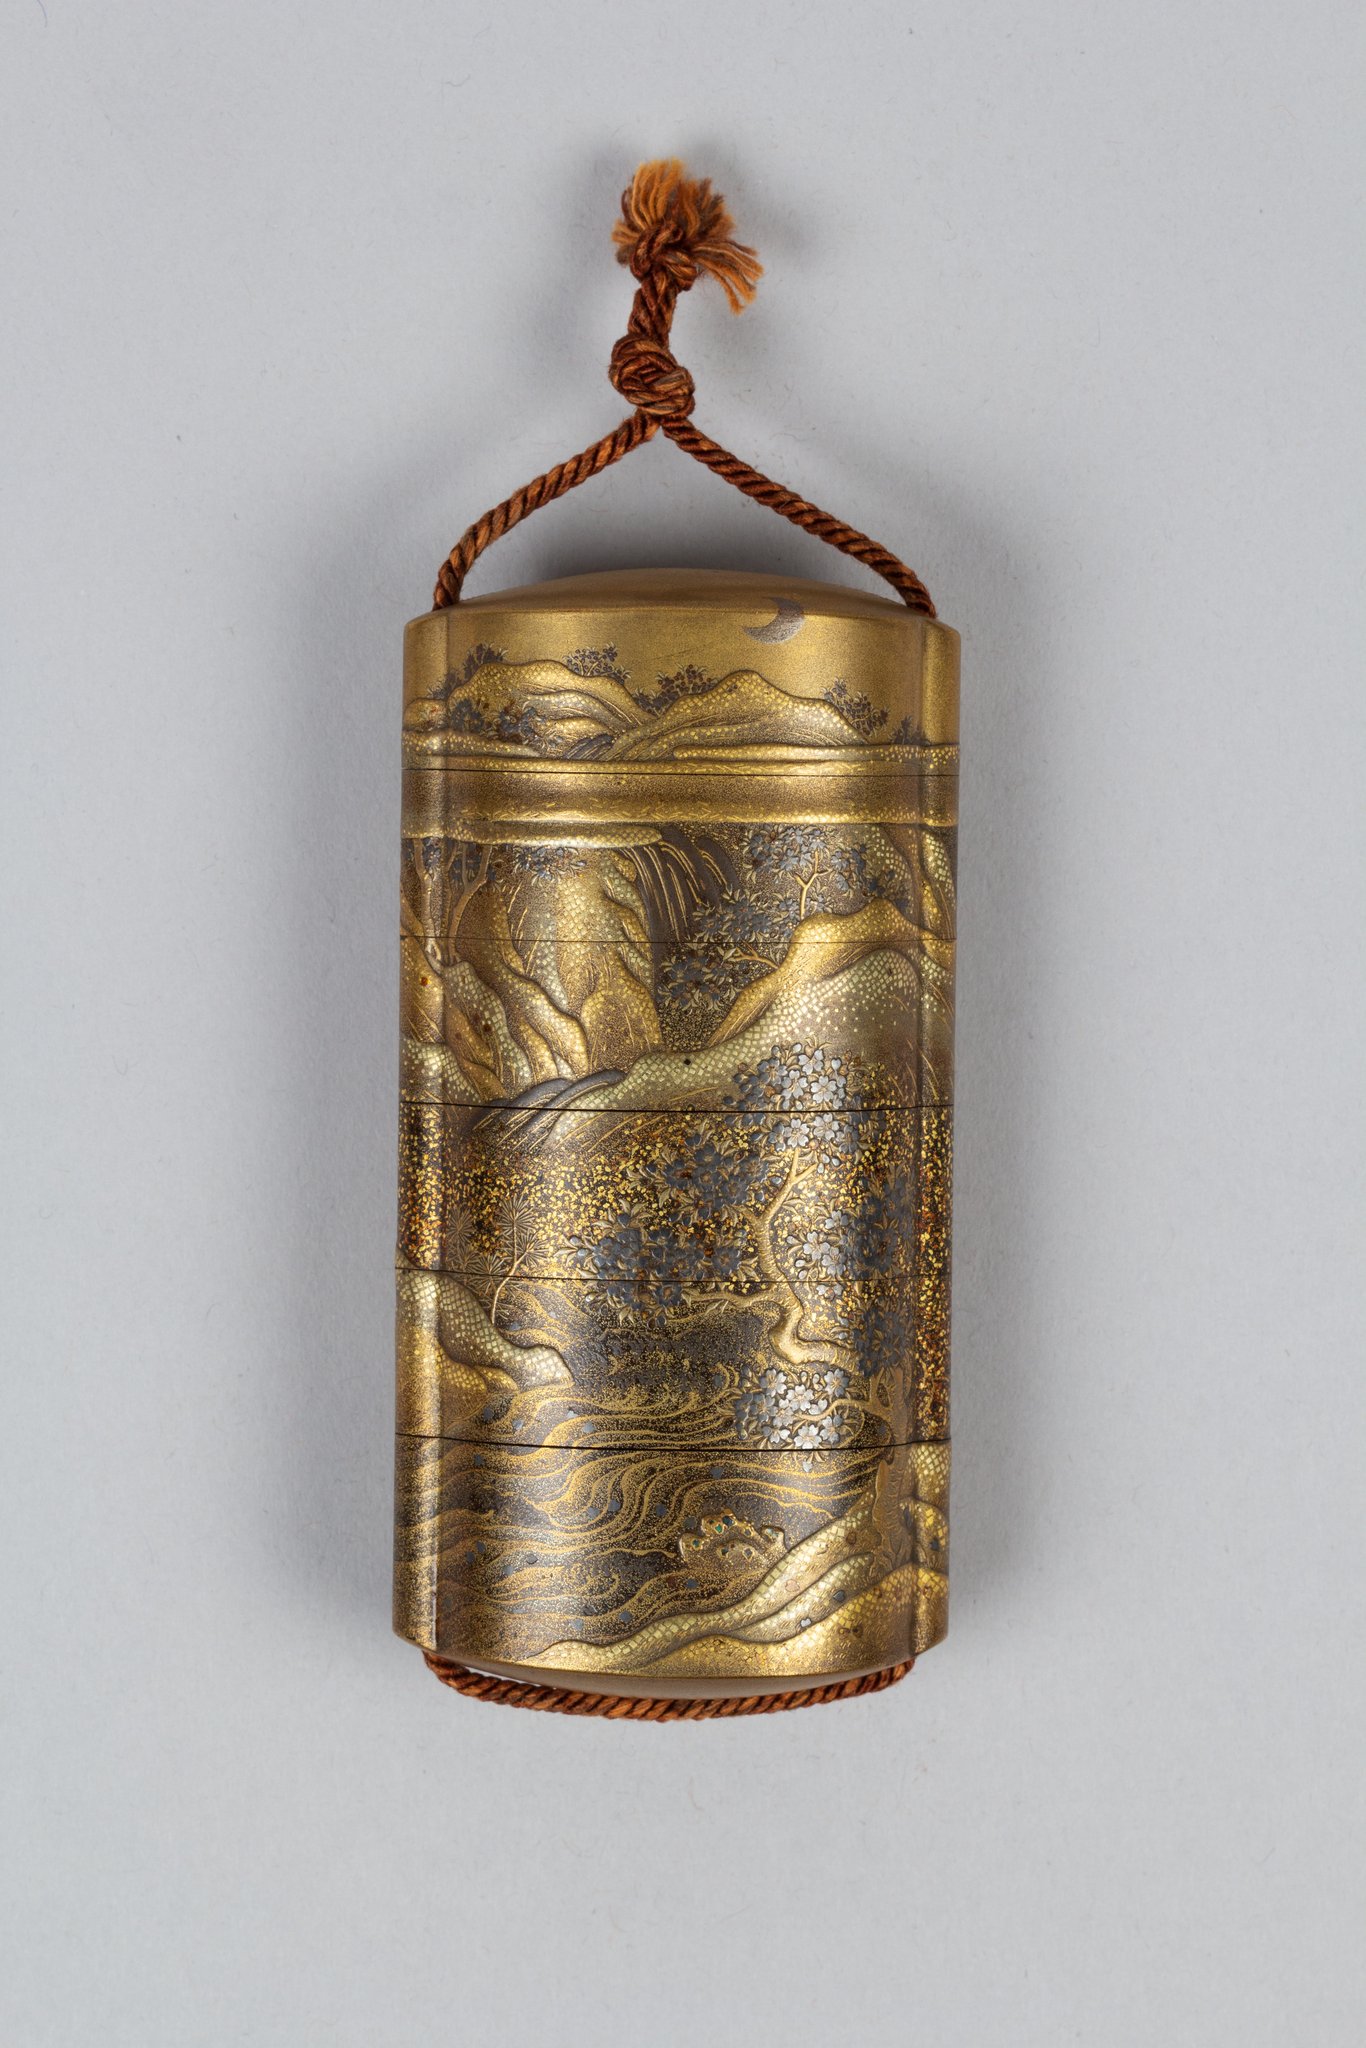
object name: inrō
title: Case (Inrō) with Design of Flowering Cherry Trees Beside Winding River (obverse); Maple Trees in Autumn (reverse)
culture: japanese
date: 1801-1900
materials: gold, lacquer, silver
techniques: fundame, hiramakie, maki-e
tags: rivers,mountains,trees,autumn